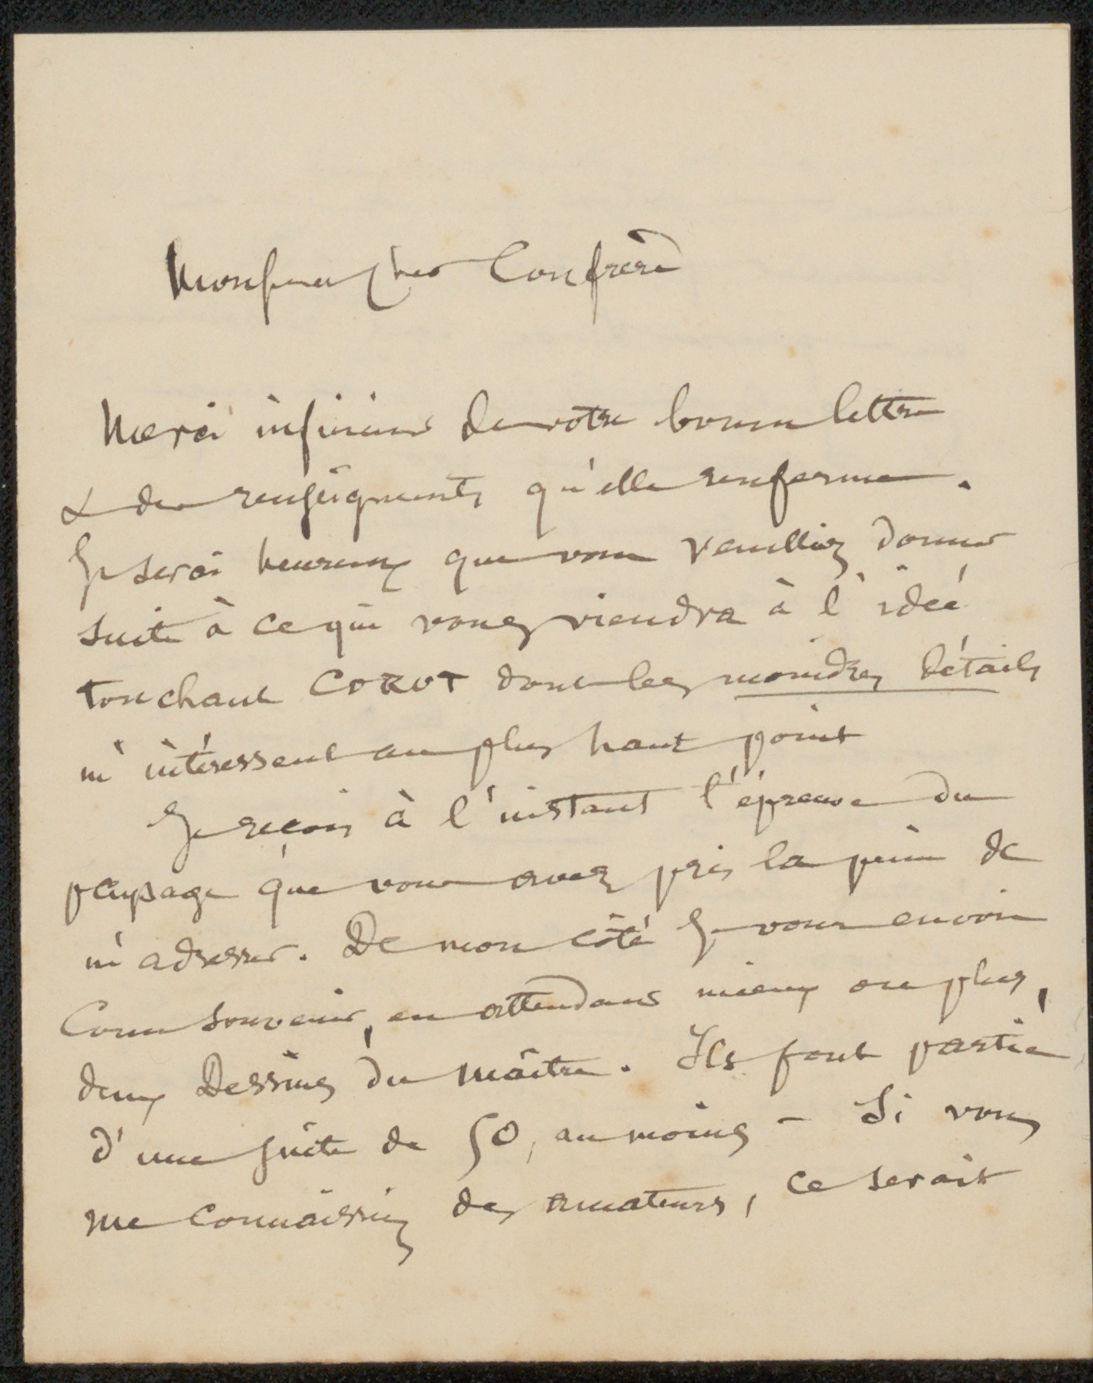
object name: letter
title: Brief aan Philip Zilcken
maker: alfred robaut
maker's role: draughtsman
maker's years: 1830-1909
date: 1887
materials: ink, paper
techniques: pen, writing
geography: paris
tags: the hague, print maker, draughtsman, hendrik willem mesdag, paris, camille corot, philip zilcken, drawing, the graphic arts, money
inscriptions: watermark, collector's mark: ‘RPK’